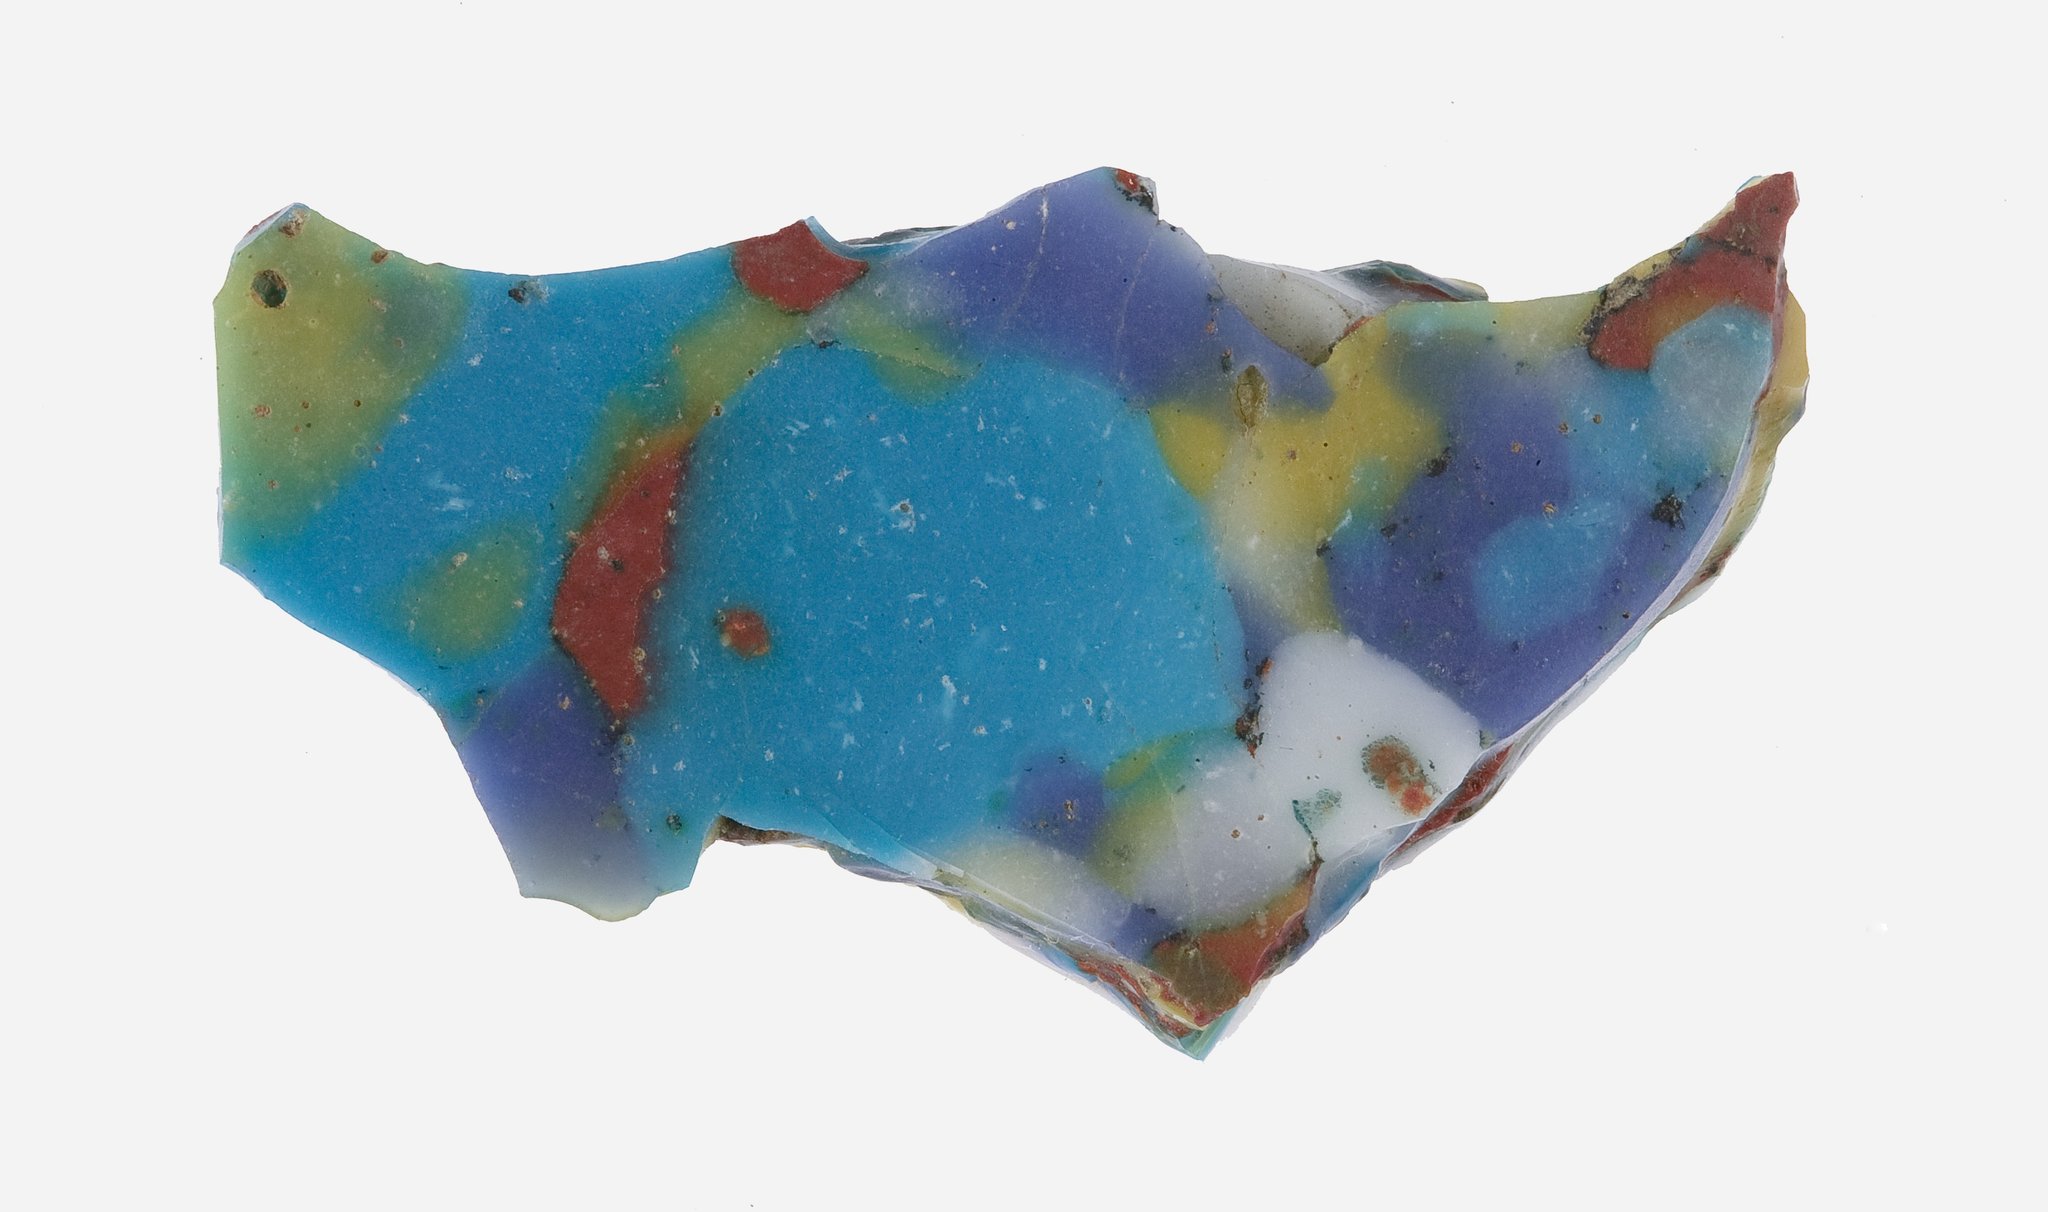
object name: vessel fragment, mosaic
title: Fragment of a Dish of Polychrome Mosaic Glass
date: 1390-1352 BCE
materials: glass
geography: egypt